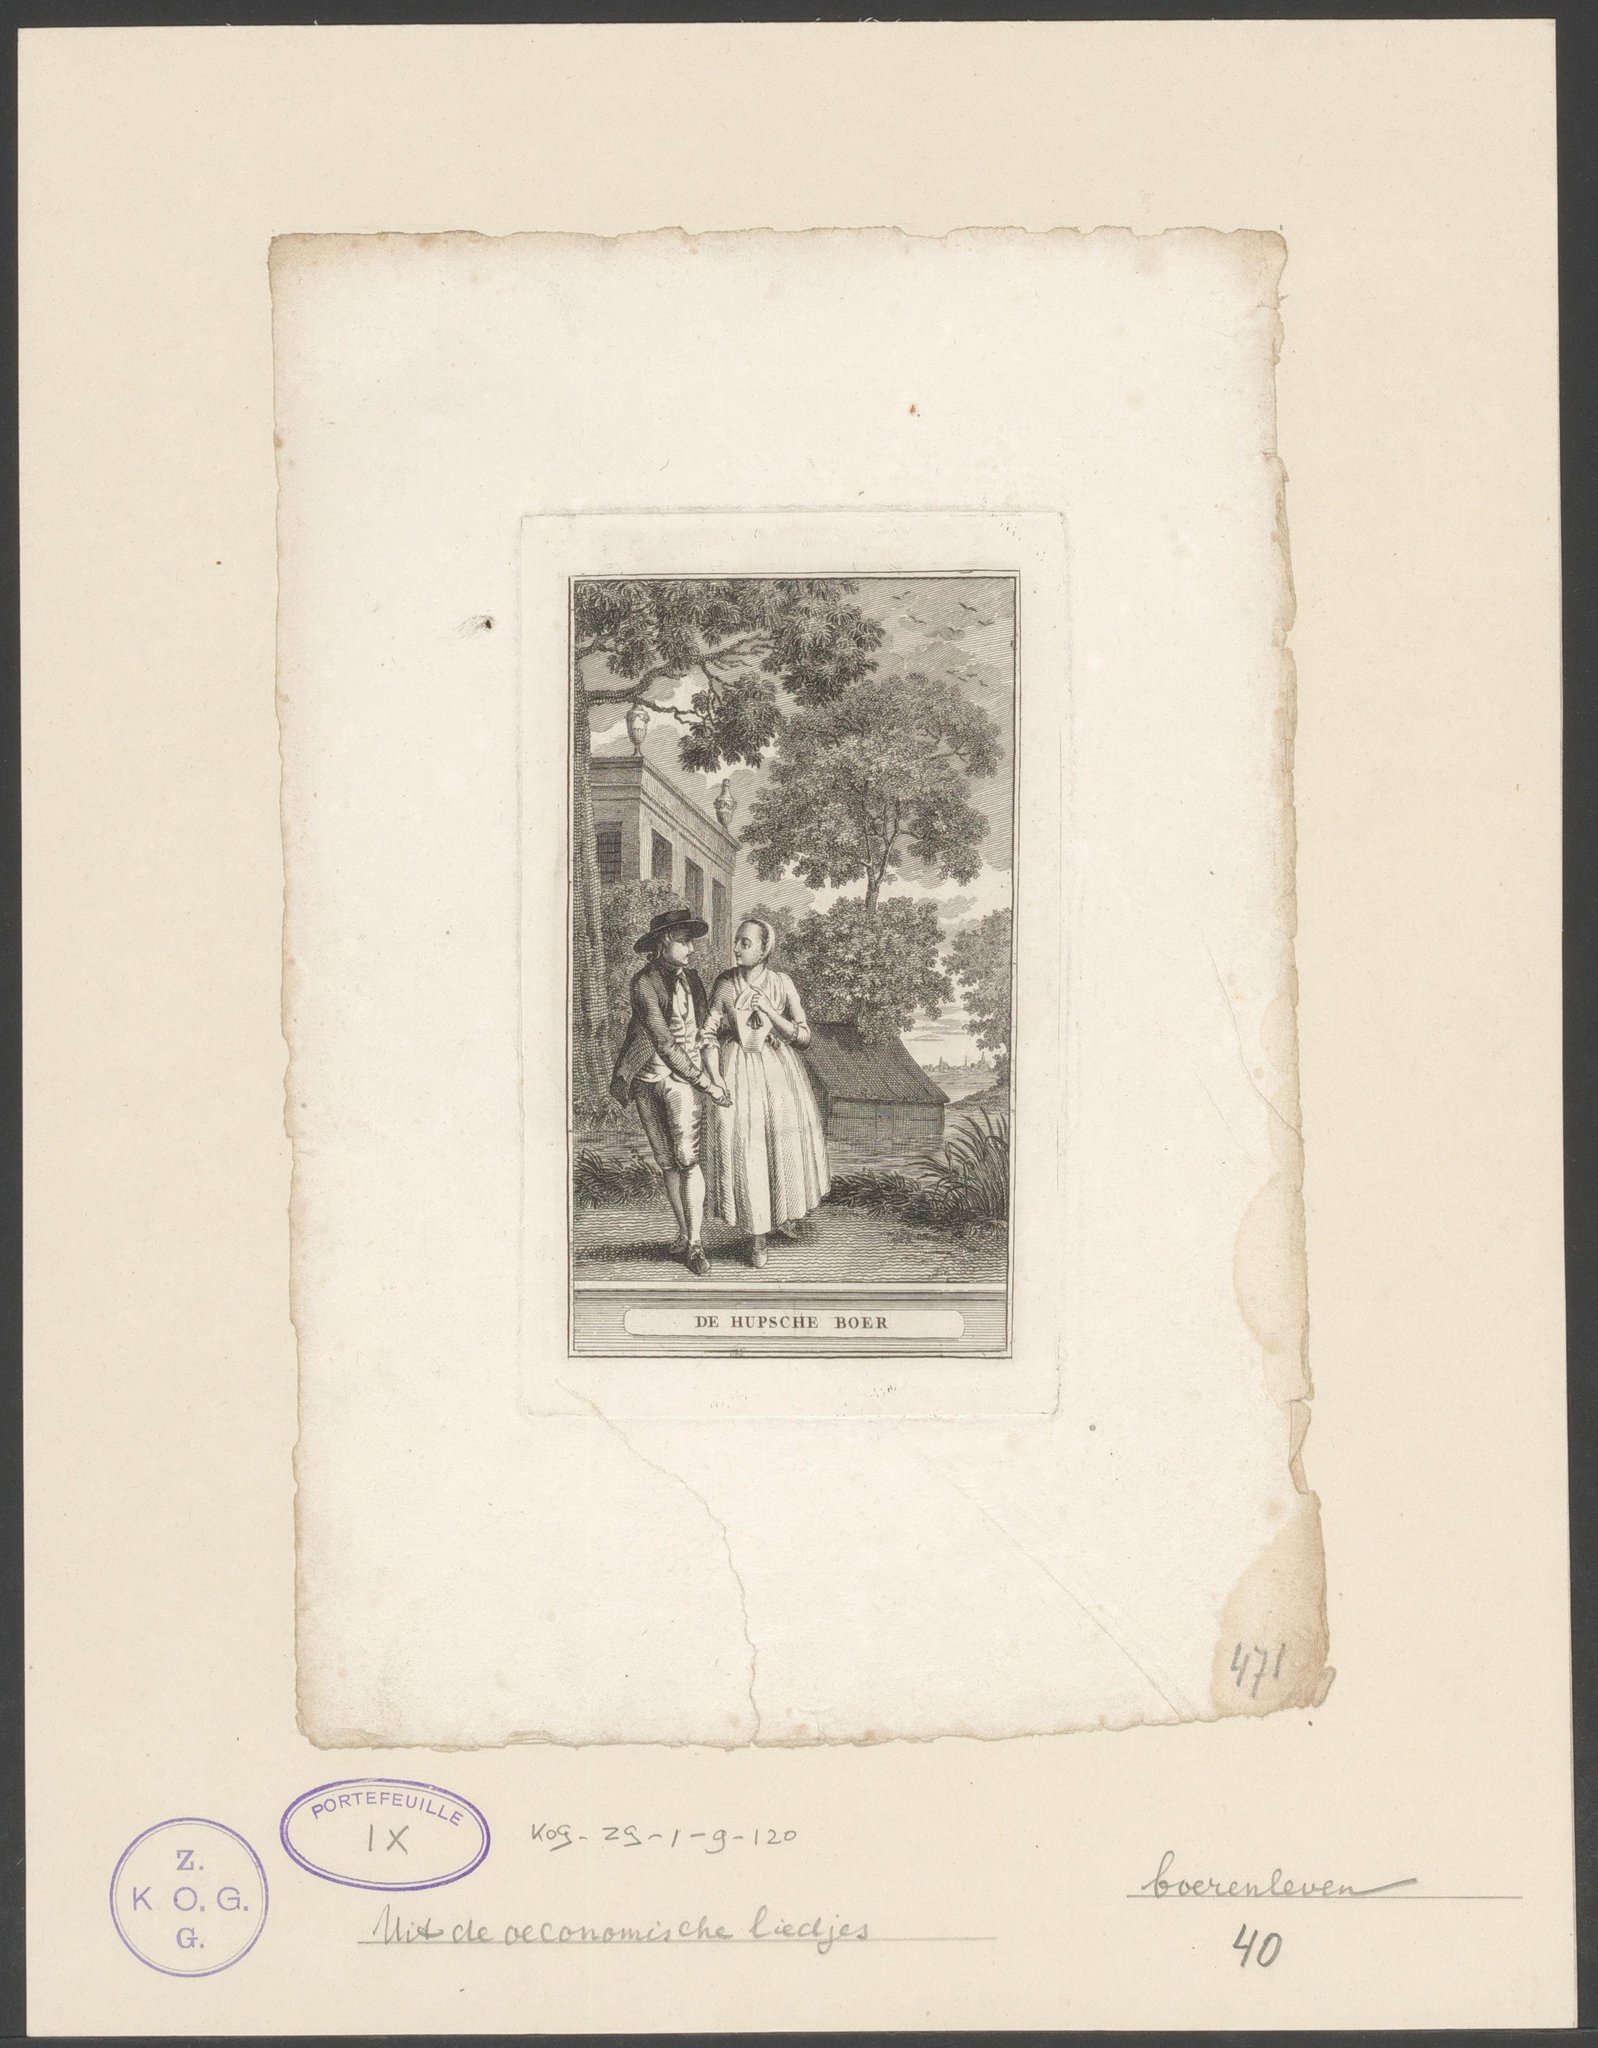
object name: print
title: De hupsche boer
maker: Anonymous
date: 1792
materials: paper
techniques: etching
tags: farmers, courting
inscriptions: collector's mark: Lugt 1641, stamp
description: Prent waarschijnlijk uit: Wolff, Betje. Economische liedjes: met plaaten. Den Haag: Isaac van Cleef, 1792.